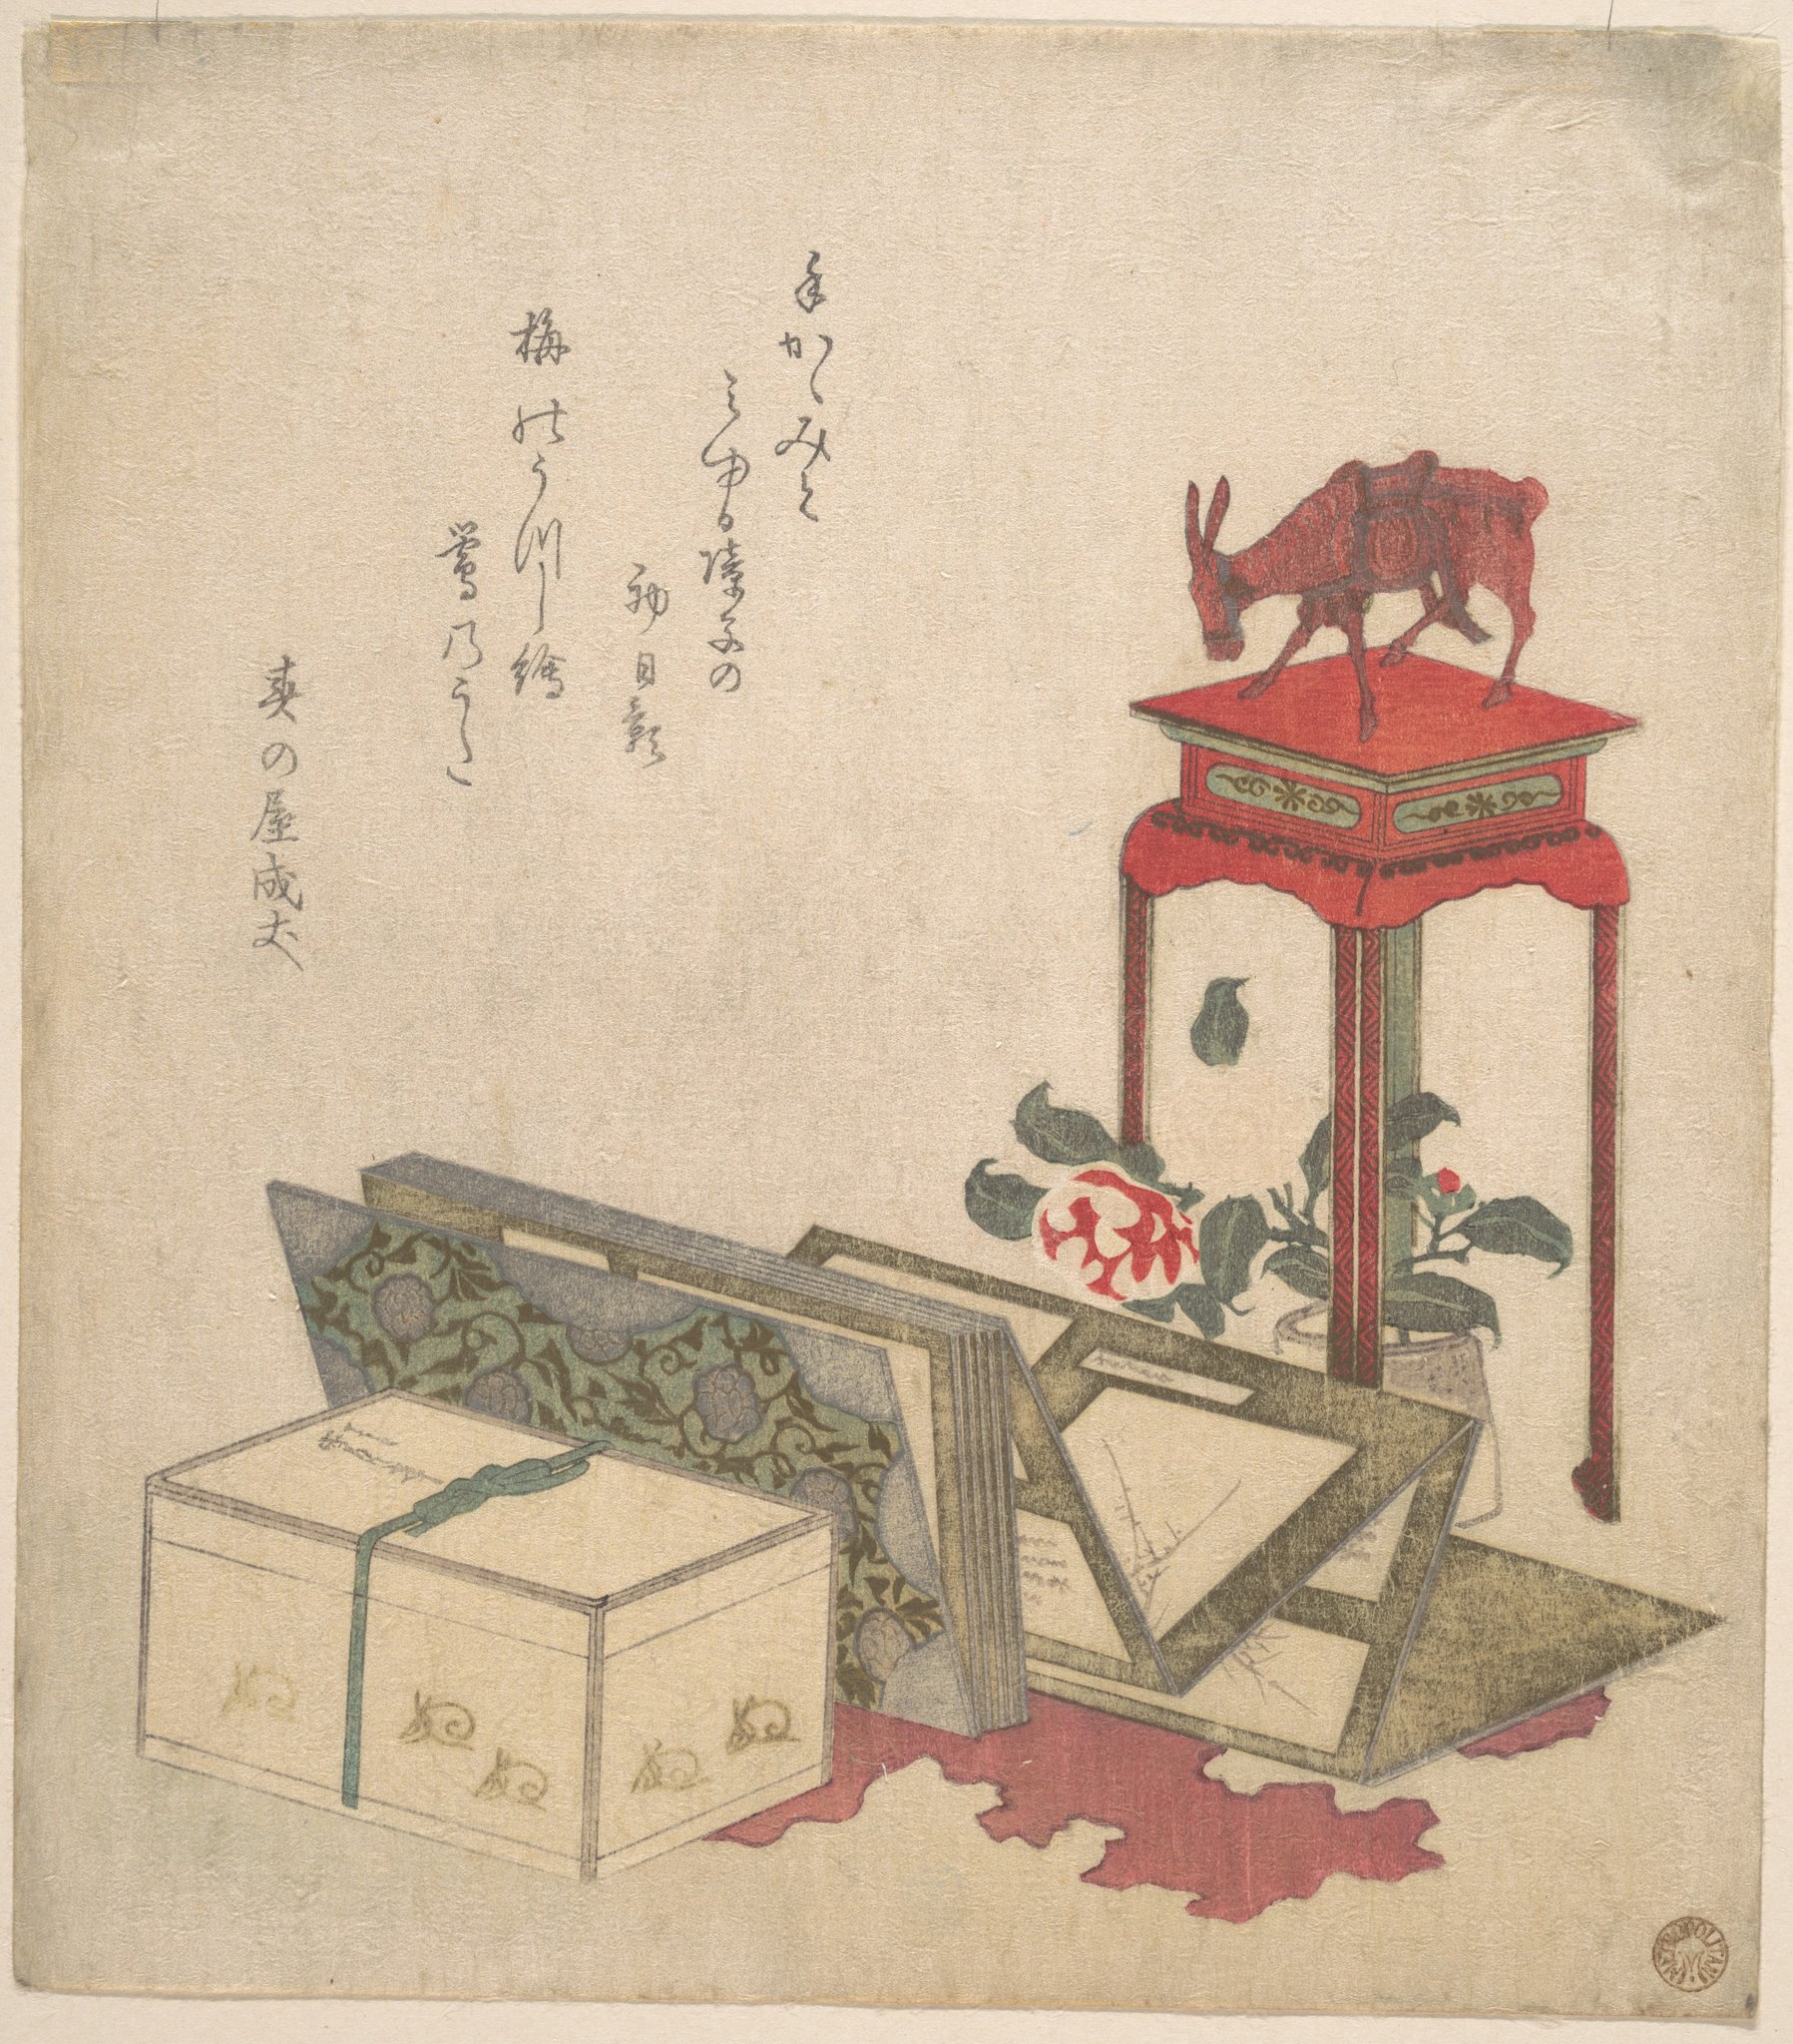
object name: print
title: Still life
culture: japanese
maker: unidentified artist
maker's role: artist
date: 1810-1822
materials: ink, paper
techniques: surimono, woodblock print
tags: animals,still life